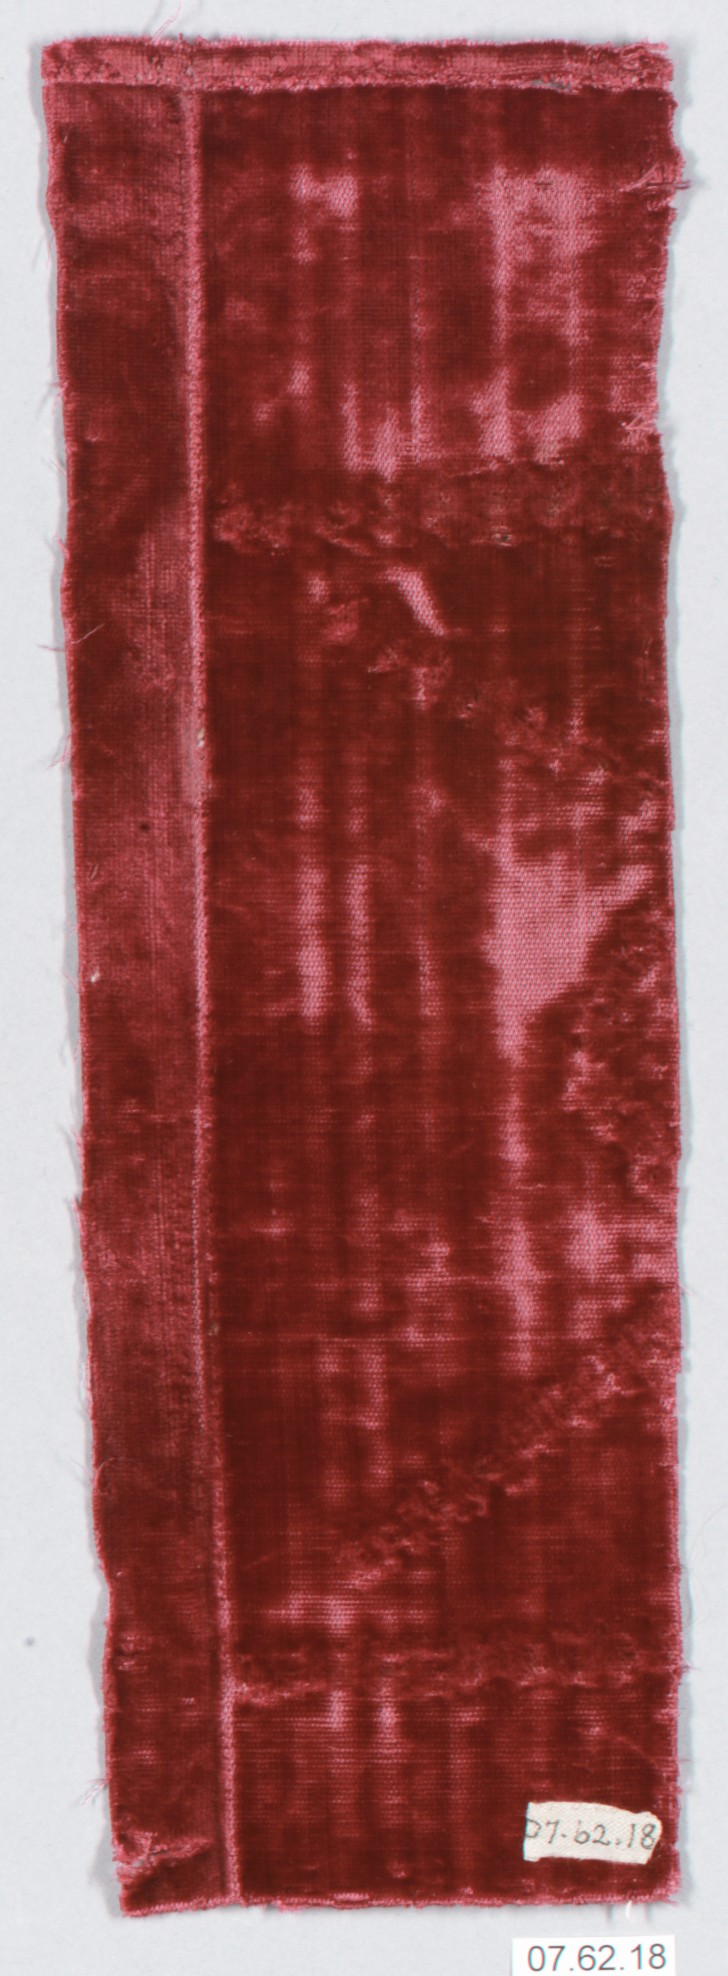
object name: piece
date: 1501-1600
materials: silk